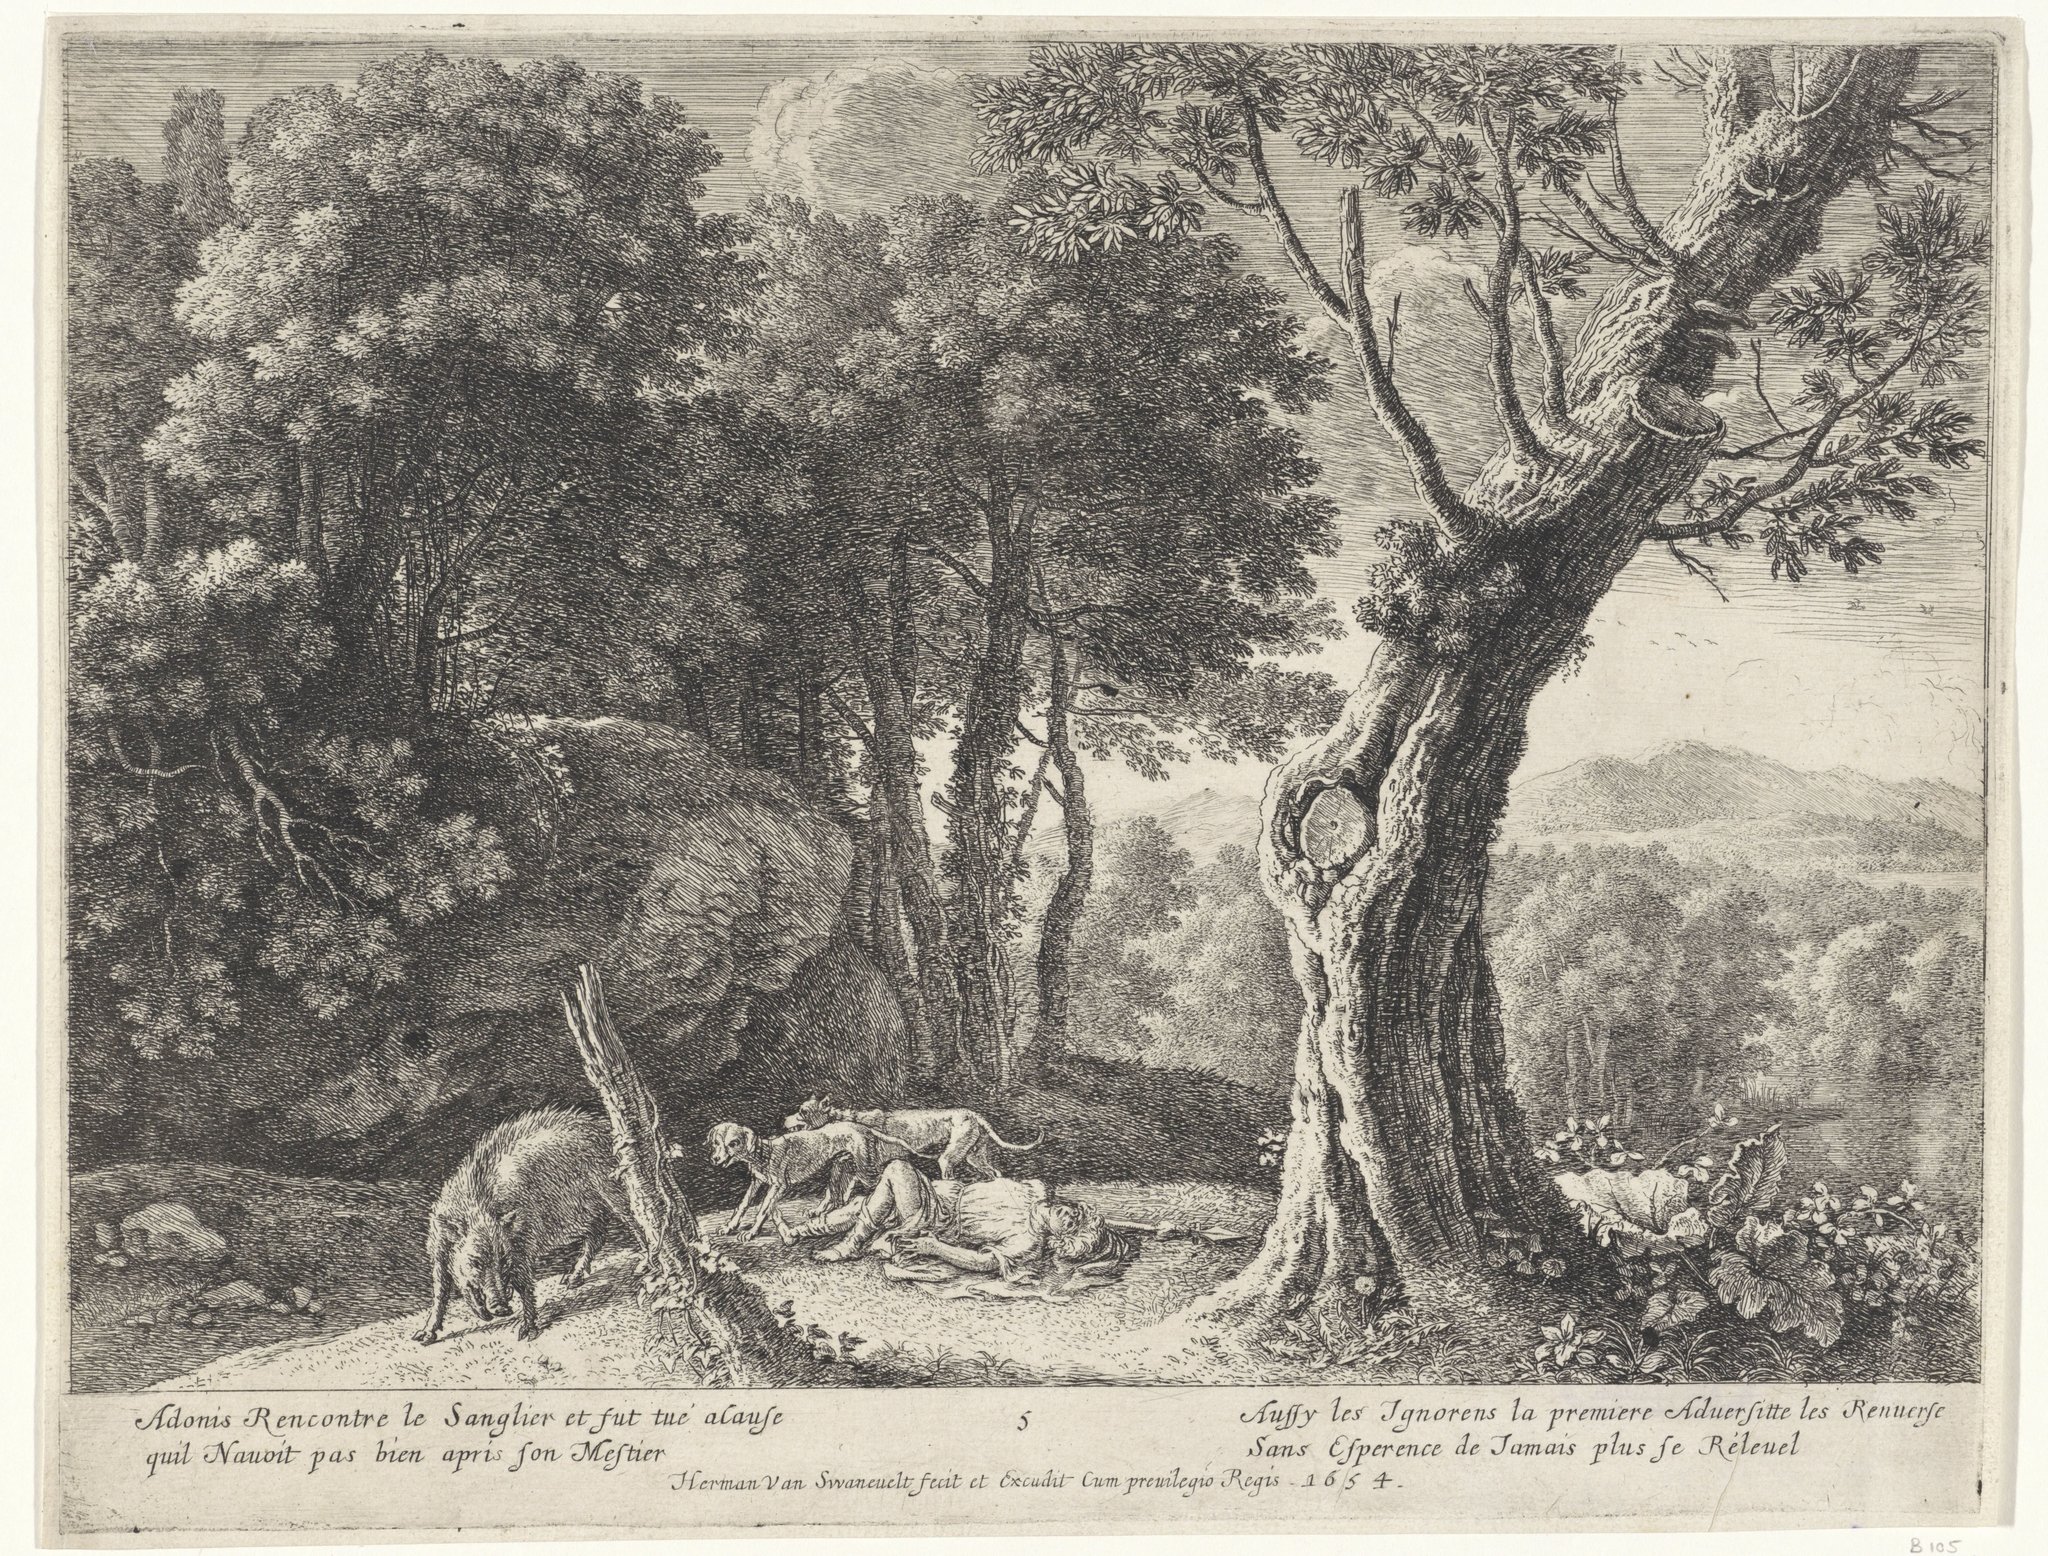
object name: print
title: Dood van Adonis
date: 1654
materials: paper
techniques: etching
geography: paris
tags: death of adonis: he is killed by a boar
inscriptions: collector's mark: Lugt 11, collector's mark: Lugt 10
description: In een heuvelachtig landschap met boompartijen en een waterpartij ligt de stervende Adonis met opgetrokken linkerbeen naast zijn speer. Rechts van hem zijn twee honden te zien en voor hem staat het zwijn dat hem aangevallen heeft. Onderaan wordt de episode in het verhaal toegelicht in een vierregelige, Franse tekst.